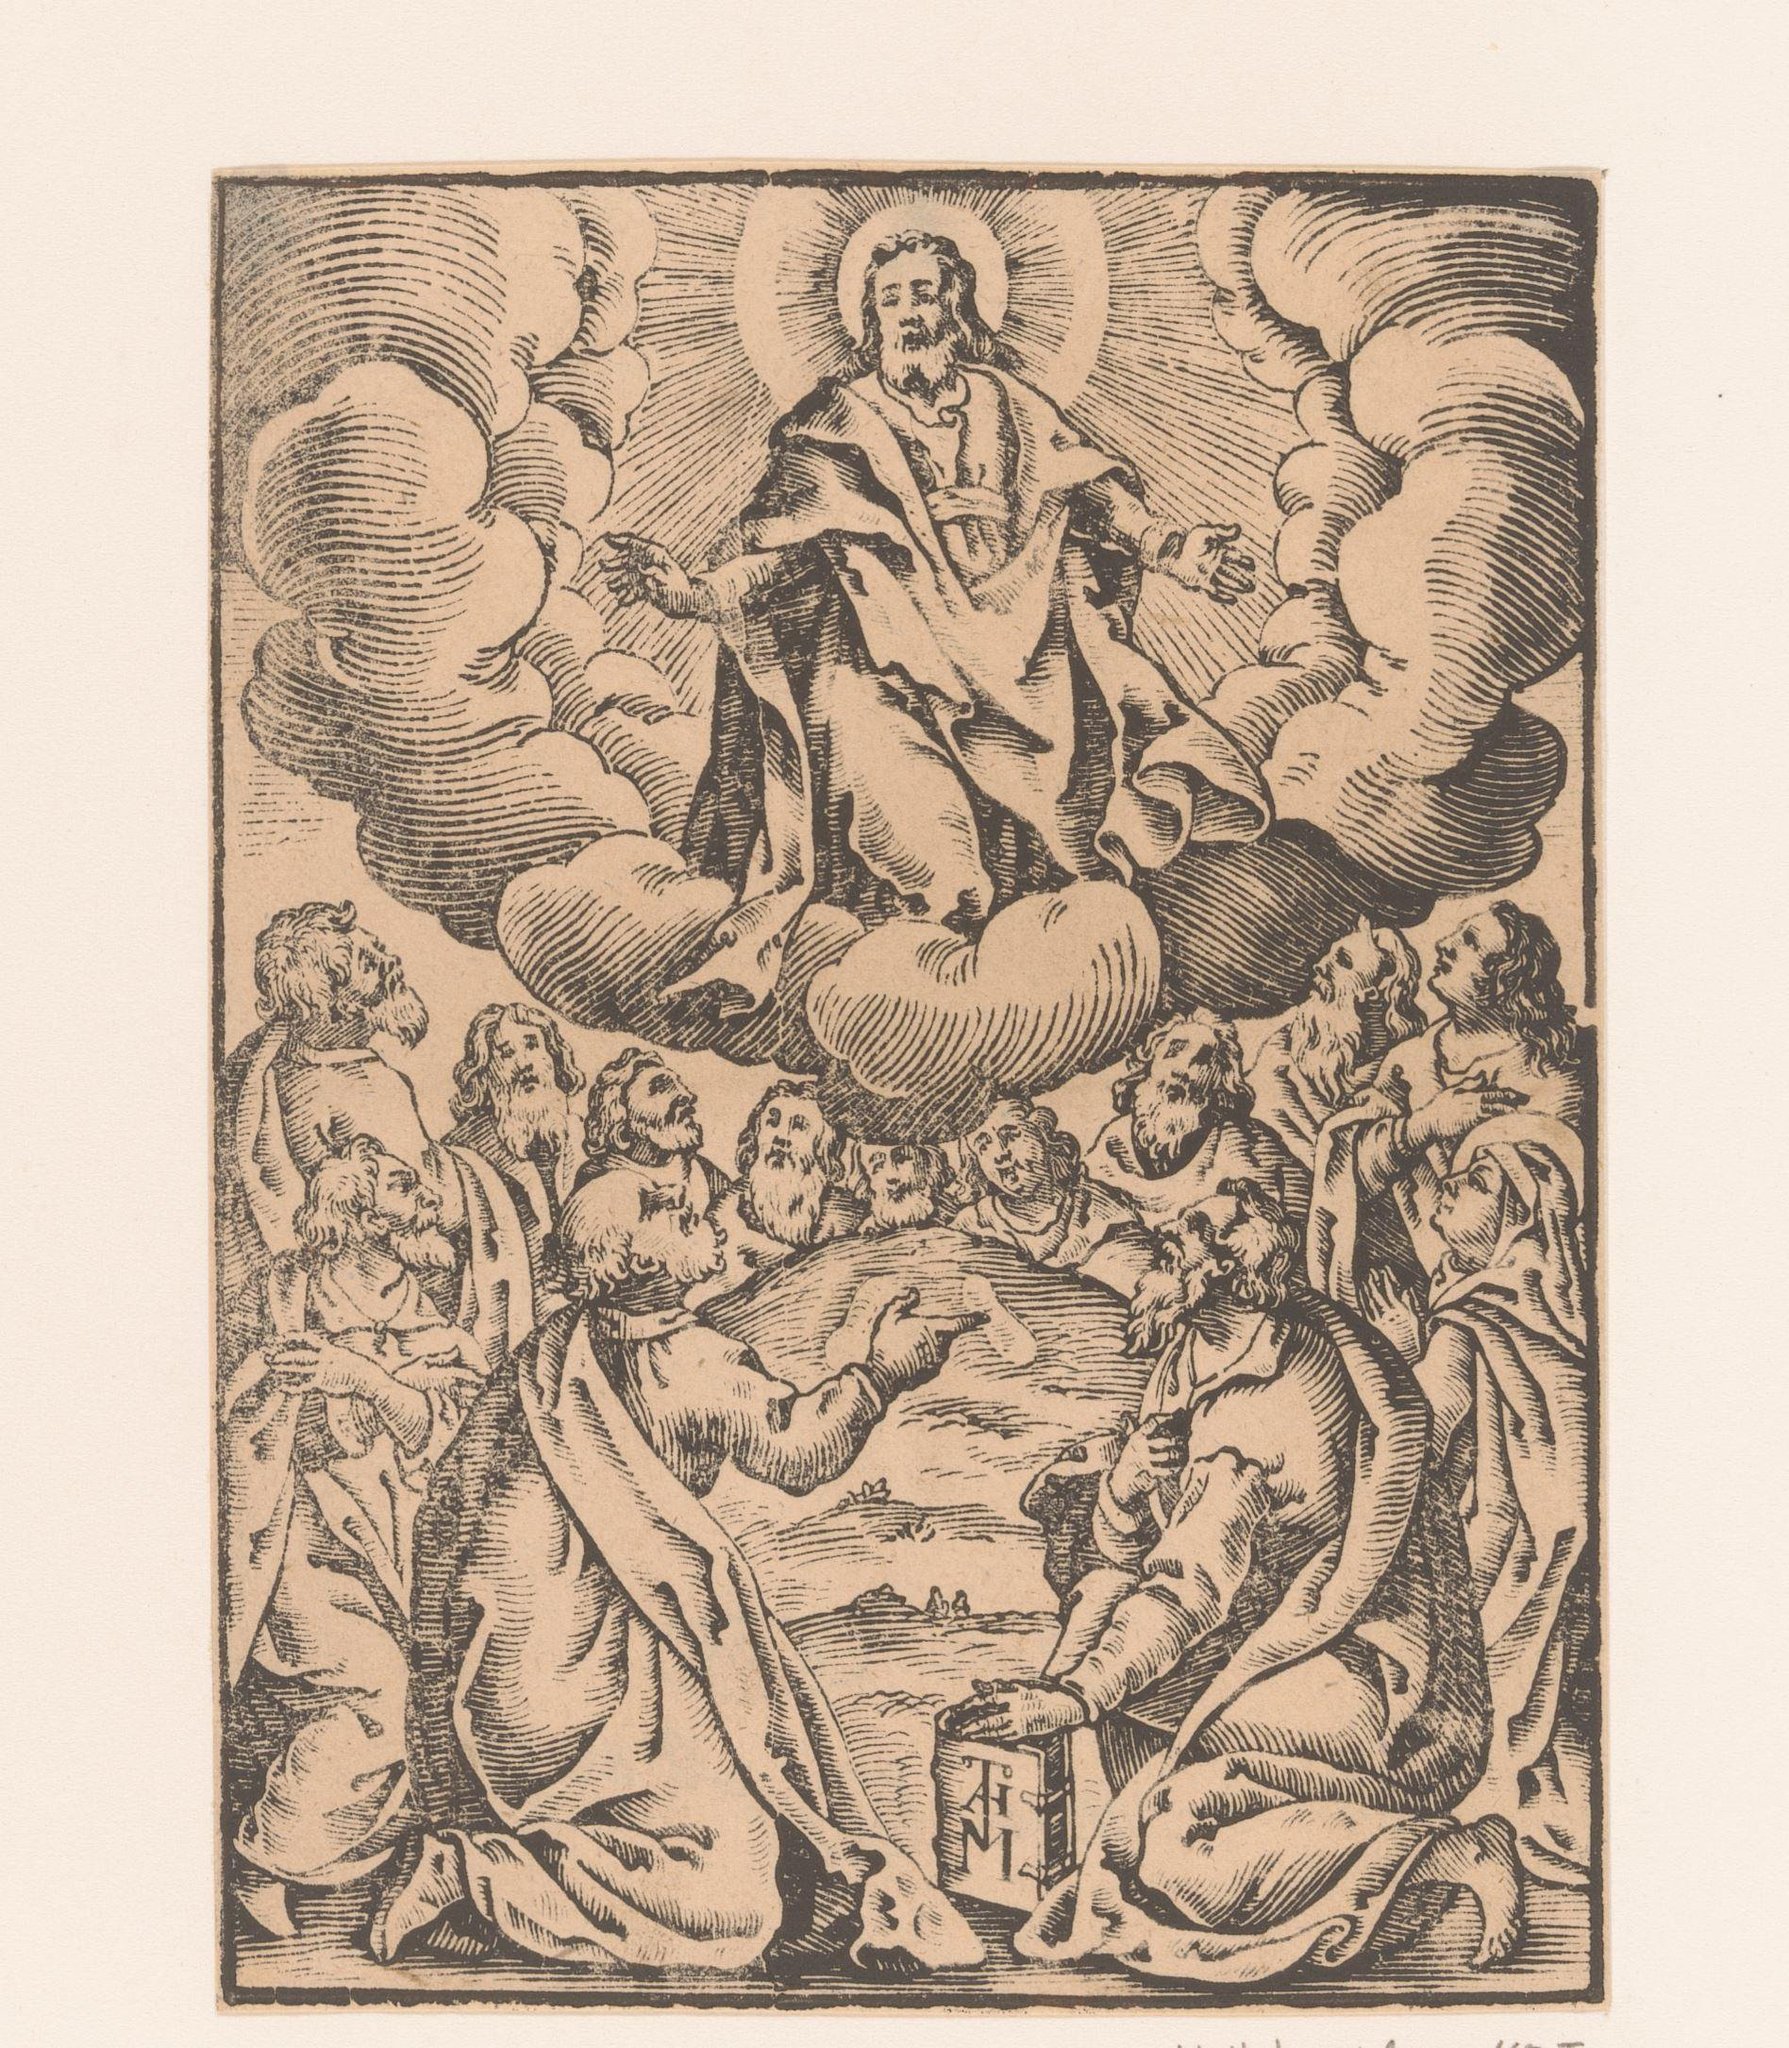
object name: print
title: Leven van Christus, evangeslisten en heiligen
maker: marx anton hannas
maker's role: print maker, publisher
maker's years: 1600-1676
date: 1610-1676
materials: paper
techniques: woodcut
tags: the ascension (christ surrounded by radiant light or in a mandorla)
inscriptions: collector's mark: Lugt 2228